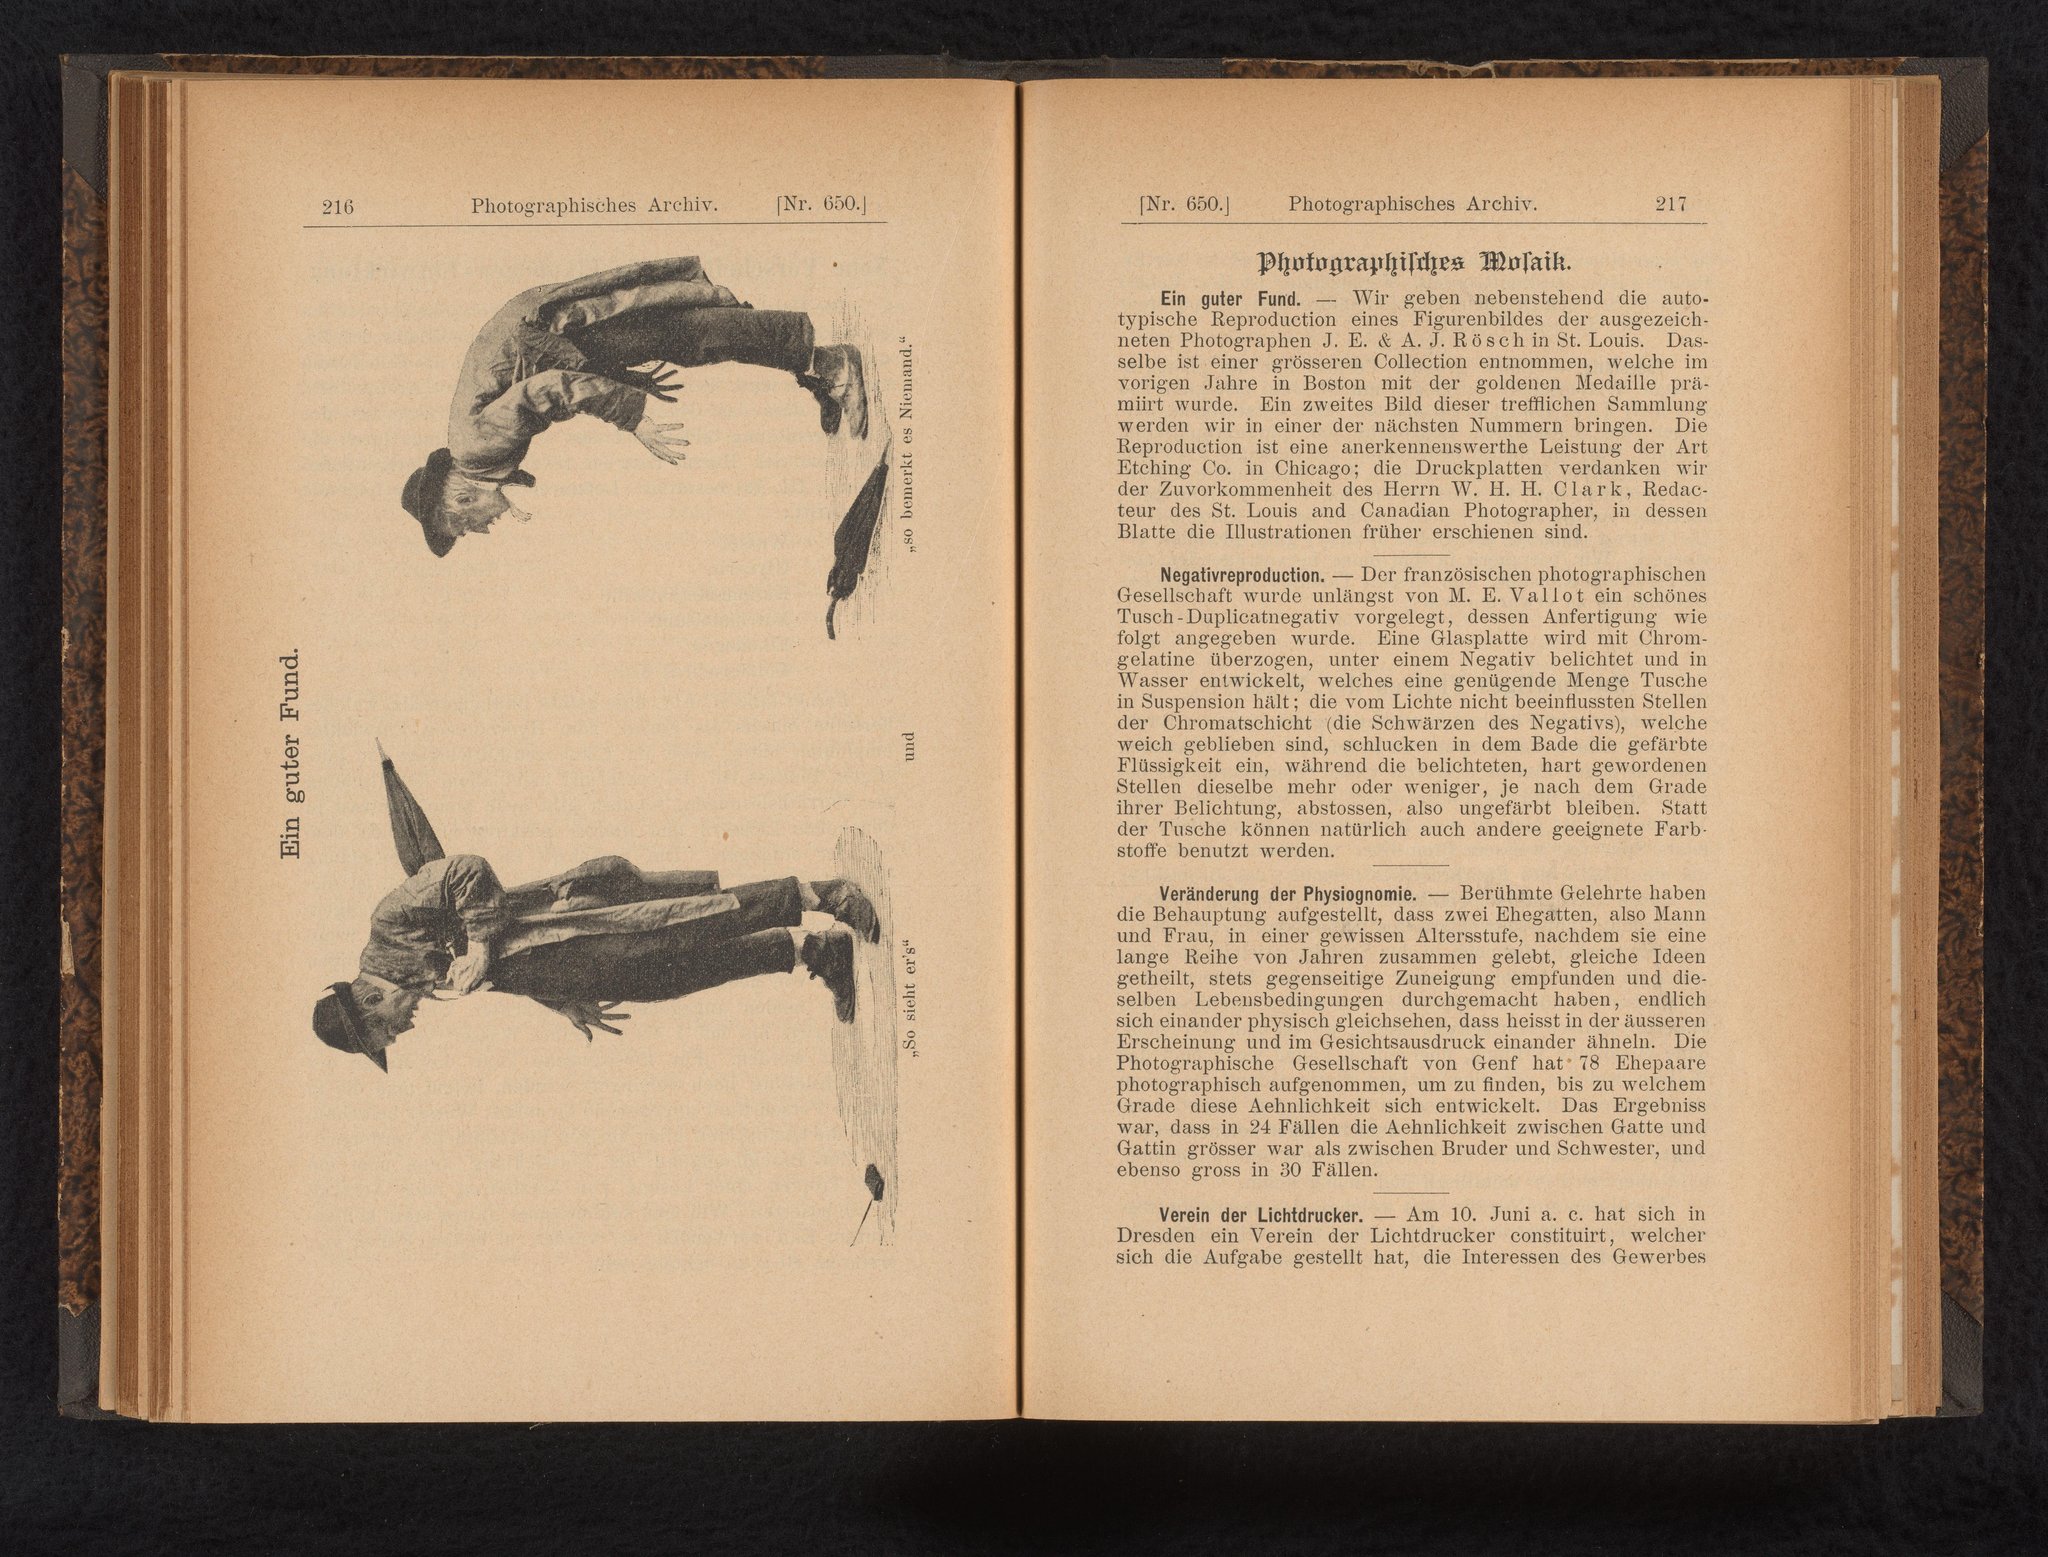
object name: photomechanical print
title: Ein guter Fund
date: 1885-1890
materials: paper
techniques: autotype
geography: saint louis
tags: purse, money-bag, adult man, umbrella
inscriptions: inscription: ‘"So sieht er's" und "so bemerkt es Niemand."’